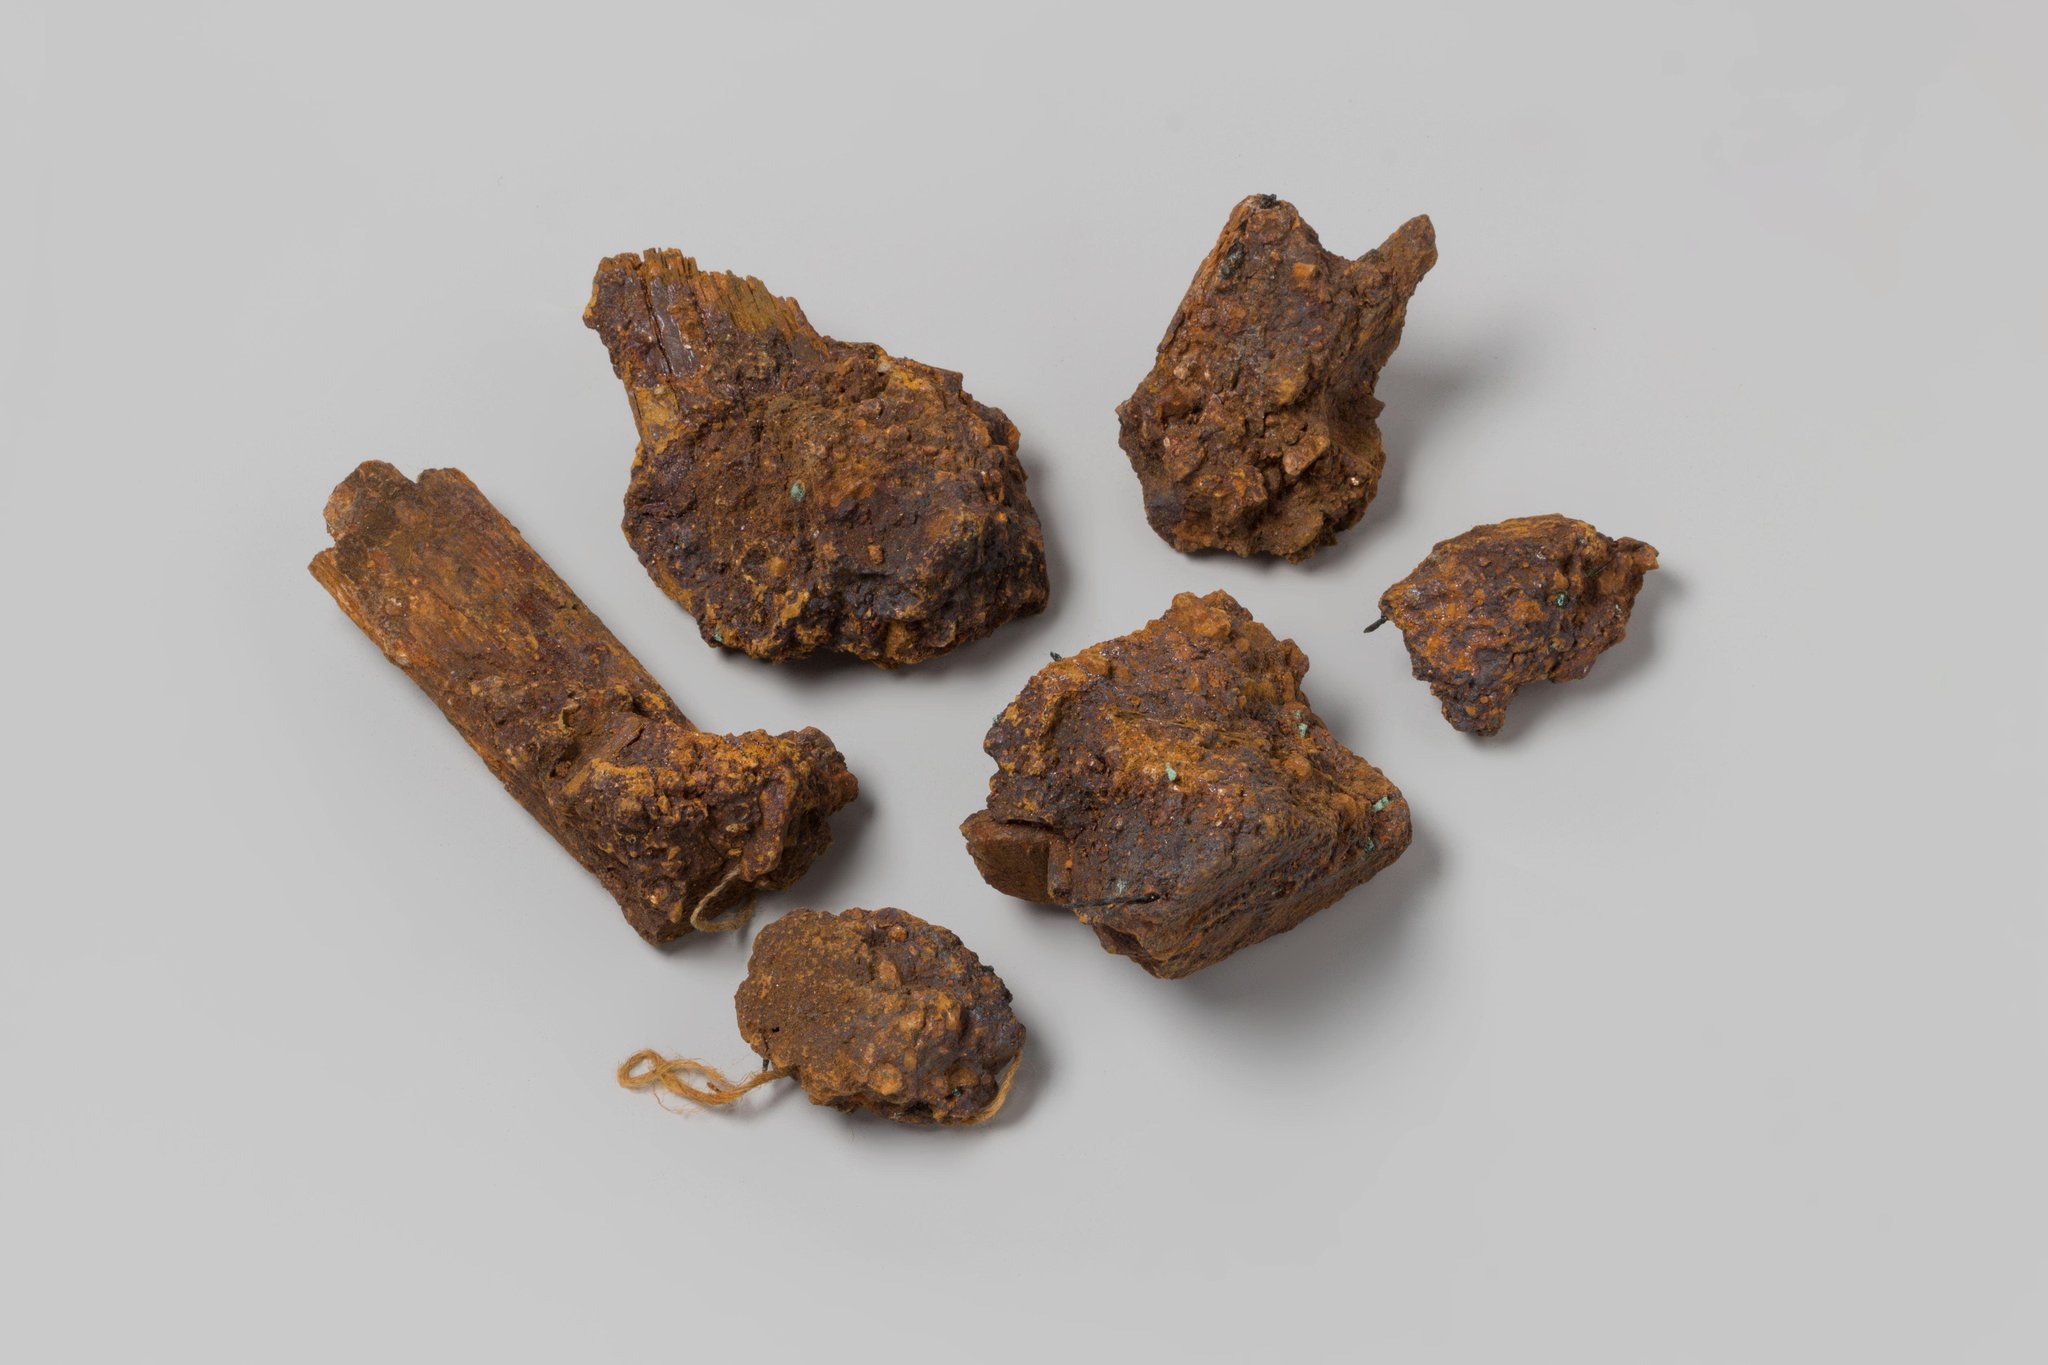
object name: concretionary stone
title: Brokken concretie met hout- en touwfragmenten en spijkers uit het wrak van de Oost-Indiëvaarder Hollandia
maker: Anonymous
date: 1700-1743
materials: stone, iron, fiber, wood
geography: netherlands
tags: verenigde oostindische compagnie, hollandia (schip), annet